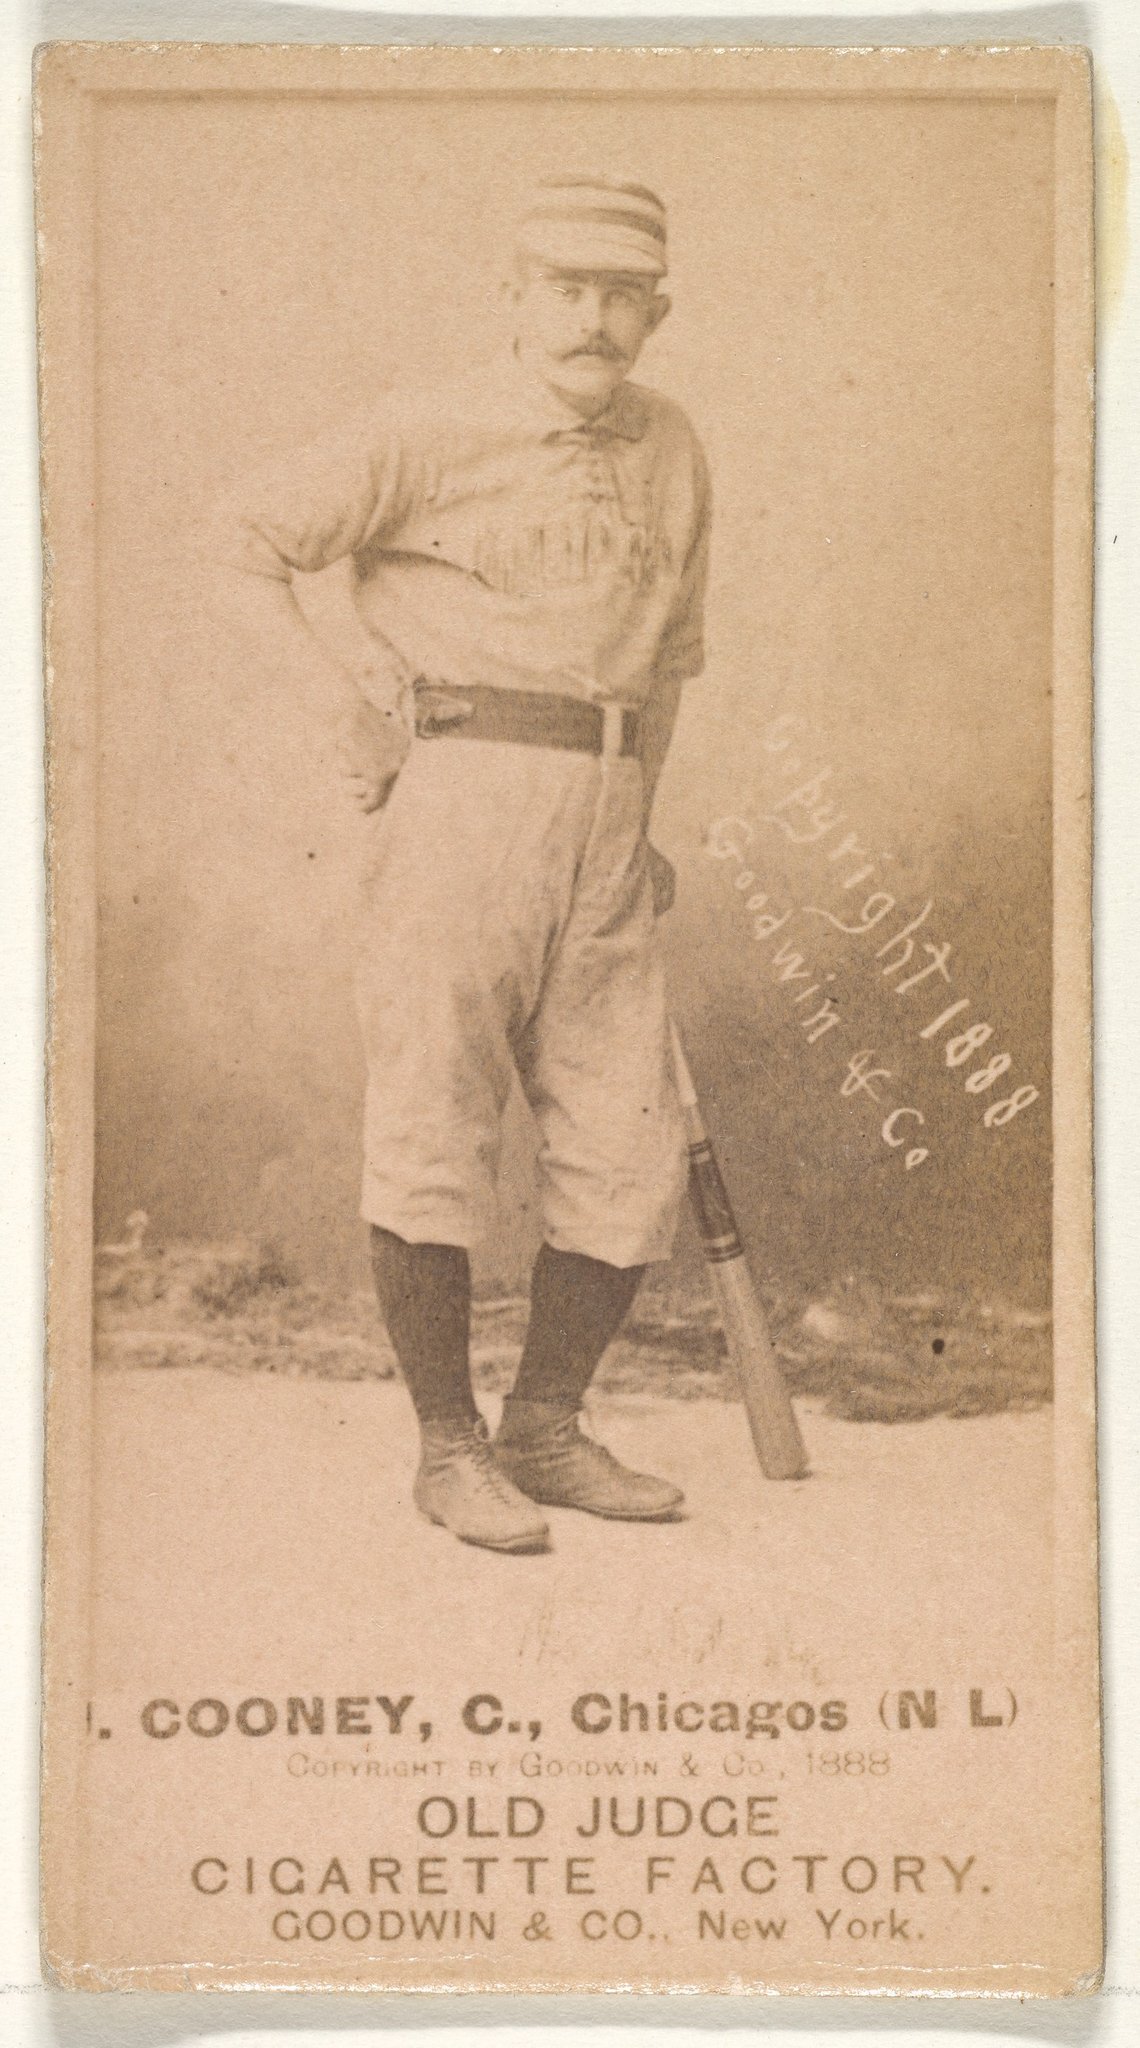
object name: baseball card, photograph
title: Cooney, Catcher, Chicago, from the Old Judge series (N172) for Old Judge Cigarettes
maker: goodwin & company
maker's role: publisher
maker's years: 1850-1950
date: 1888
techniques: albumen silver print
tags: men,portraits,baseball,athletes